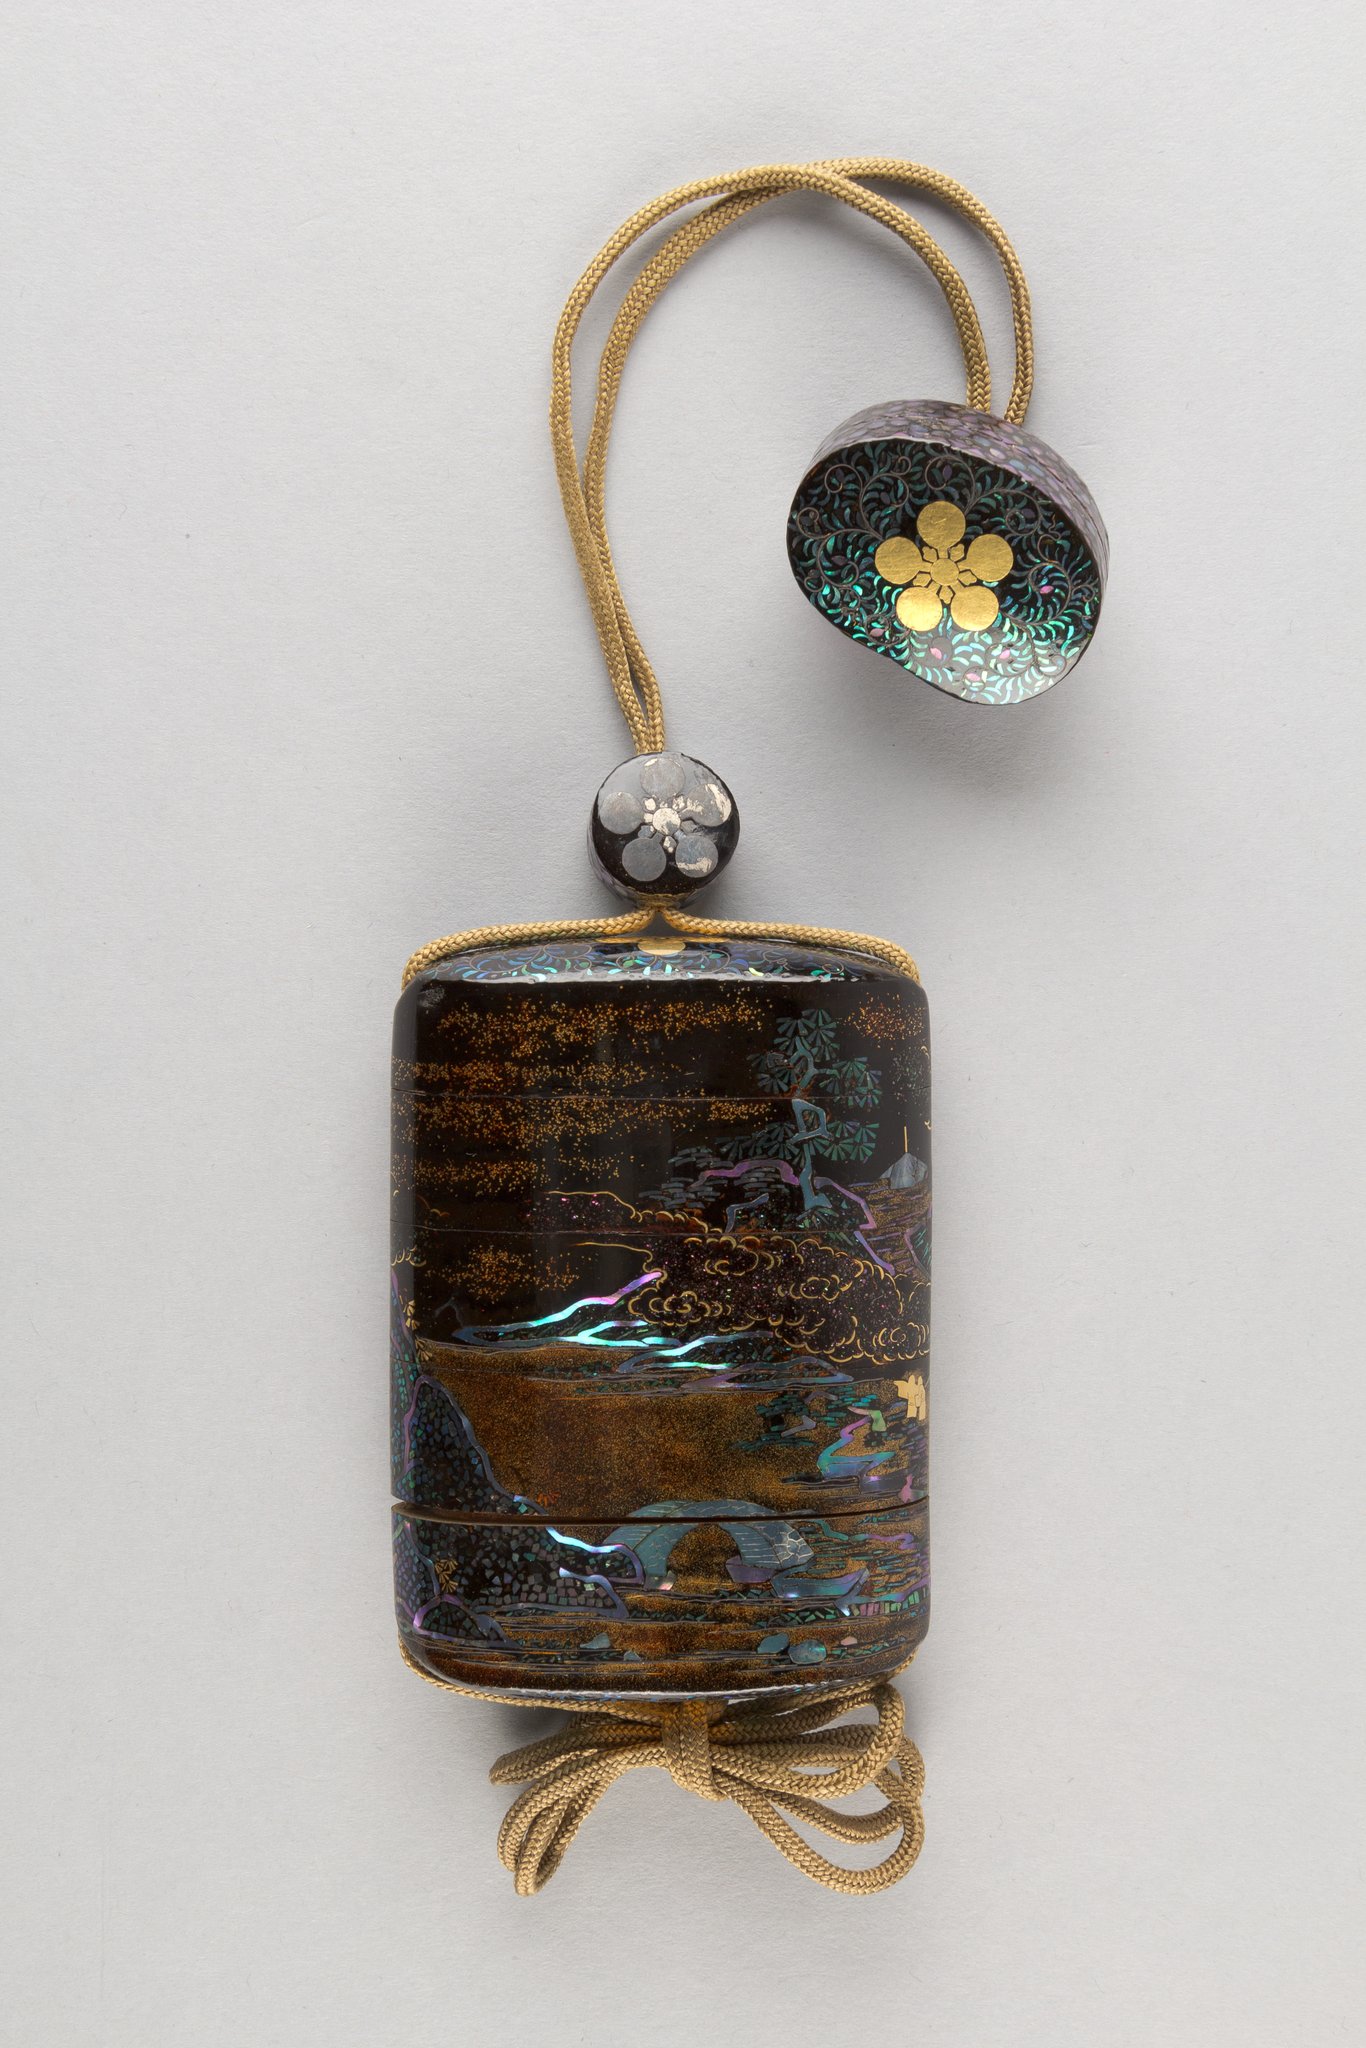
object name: inrō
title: Case (Inrō) with Chinese-Style Landscape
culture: japanese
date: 1801-1900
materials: gold foil, lacquer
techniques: fundame, inlay, roiro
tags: bridges,landscapes